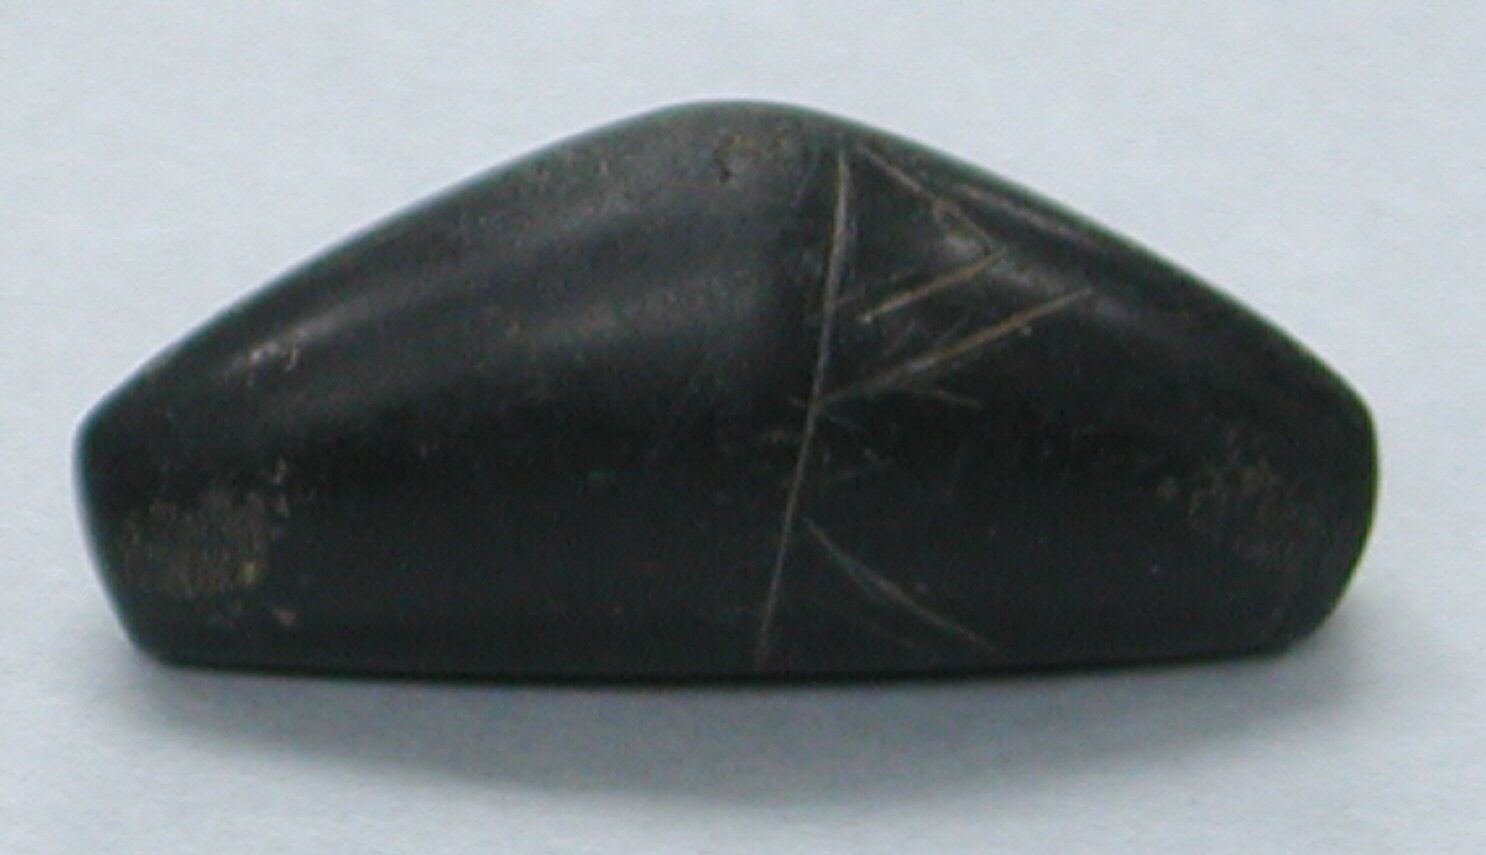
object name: ritual stone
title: Stone Pulidor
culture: mexican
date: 1501-1600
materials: stone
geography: mexico